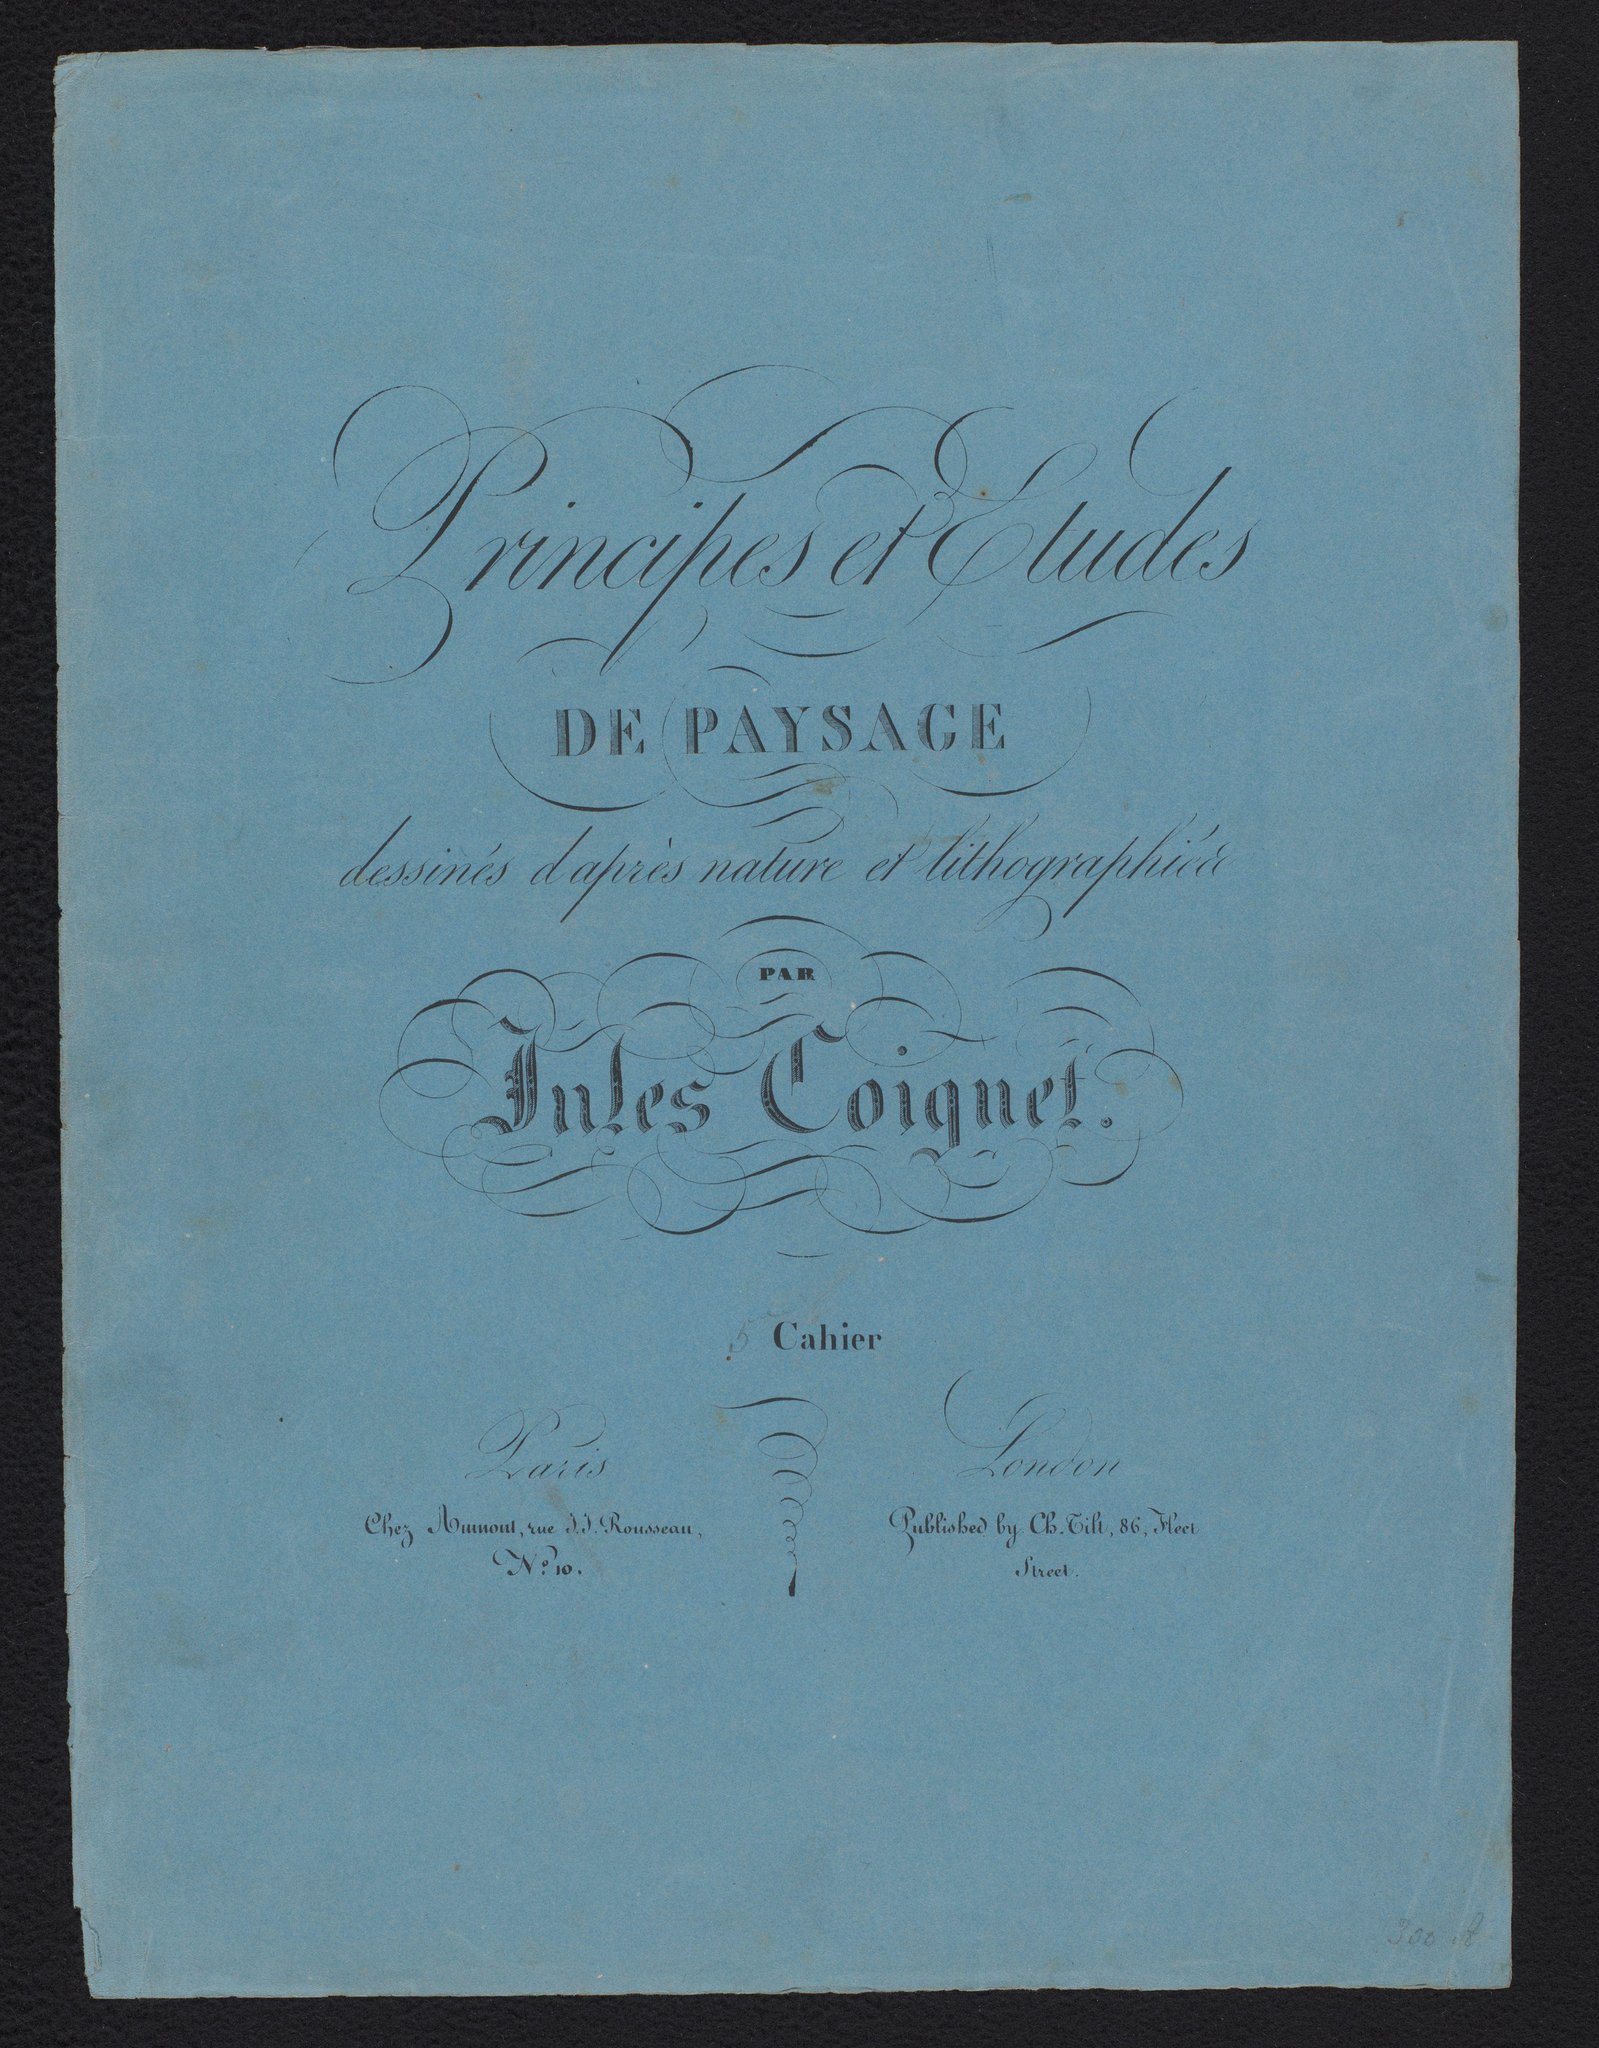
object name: wrapper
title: Omslag voor: Landschapsstudies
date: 1831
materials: paper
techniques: lithograph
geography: london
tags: calligraphy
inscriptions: collector's mark: Lugt 2228a